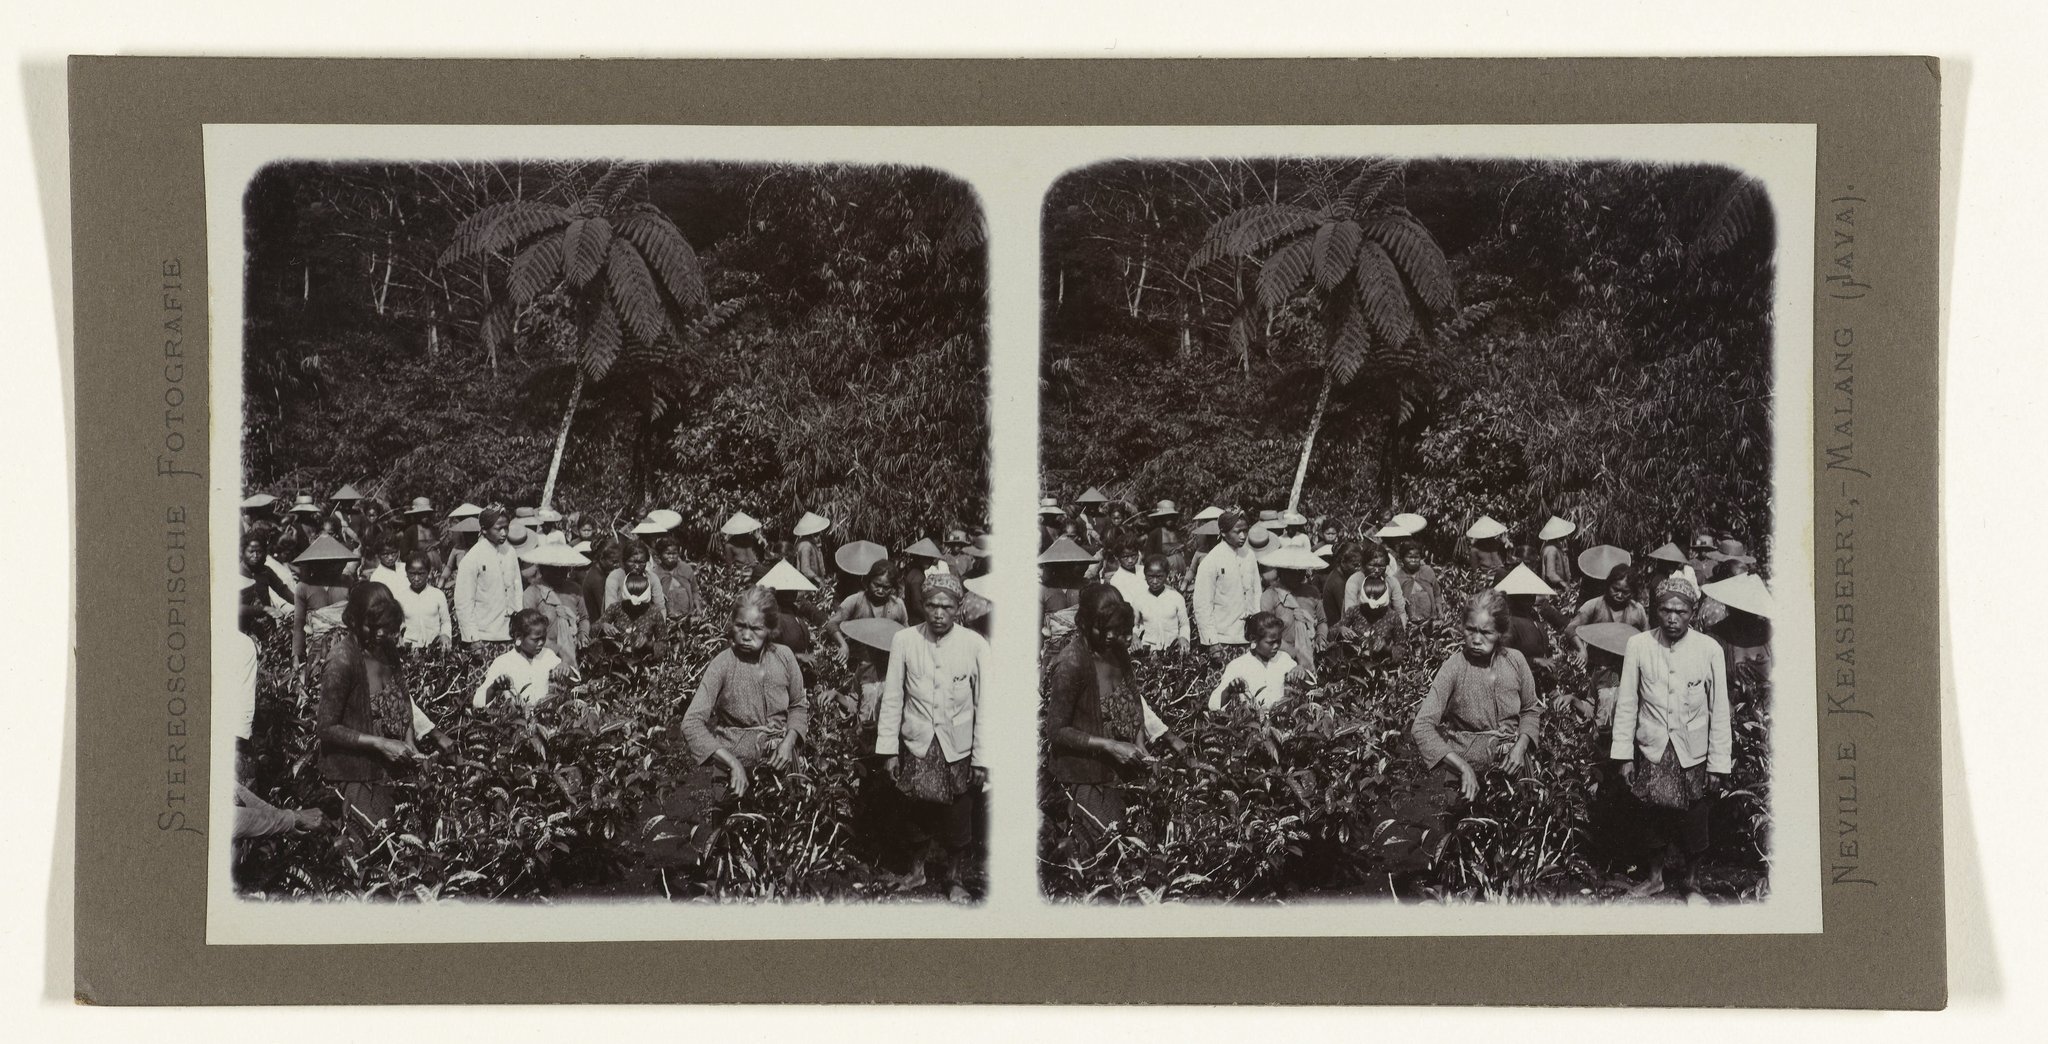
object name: stereograph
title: Javaanse vrouwen plukken thee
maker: neville keasberry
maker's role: fotograaf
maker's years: 1866-1944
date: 1900-1935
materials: cardboard, paper, photographic support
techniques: albumen print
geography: malang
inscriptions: inscription: ‘Stereoscopische Fotografie’, signature: ‘Neville Keasberry, Malang (Java)’